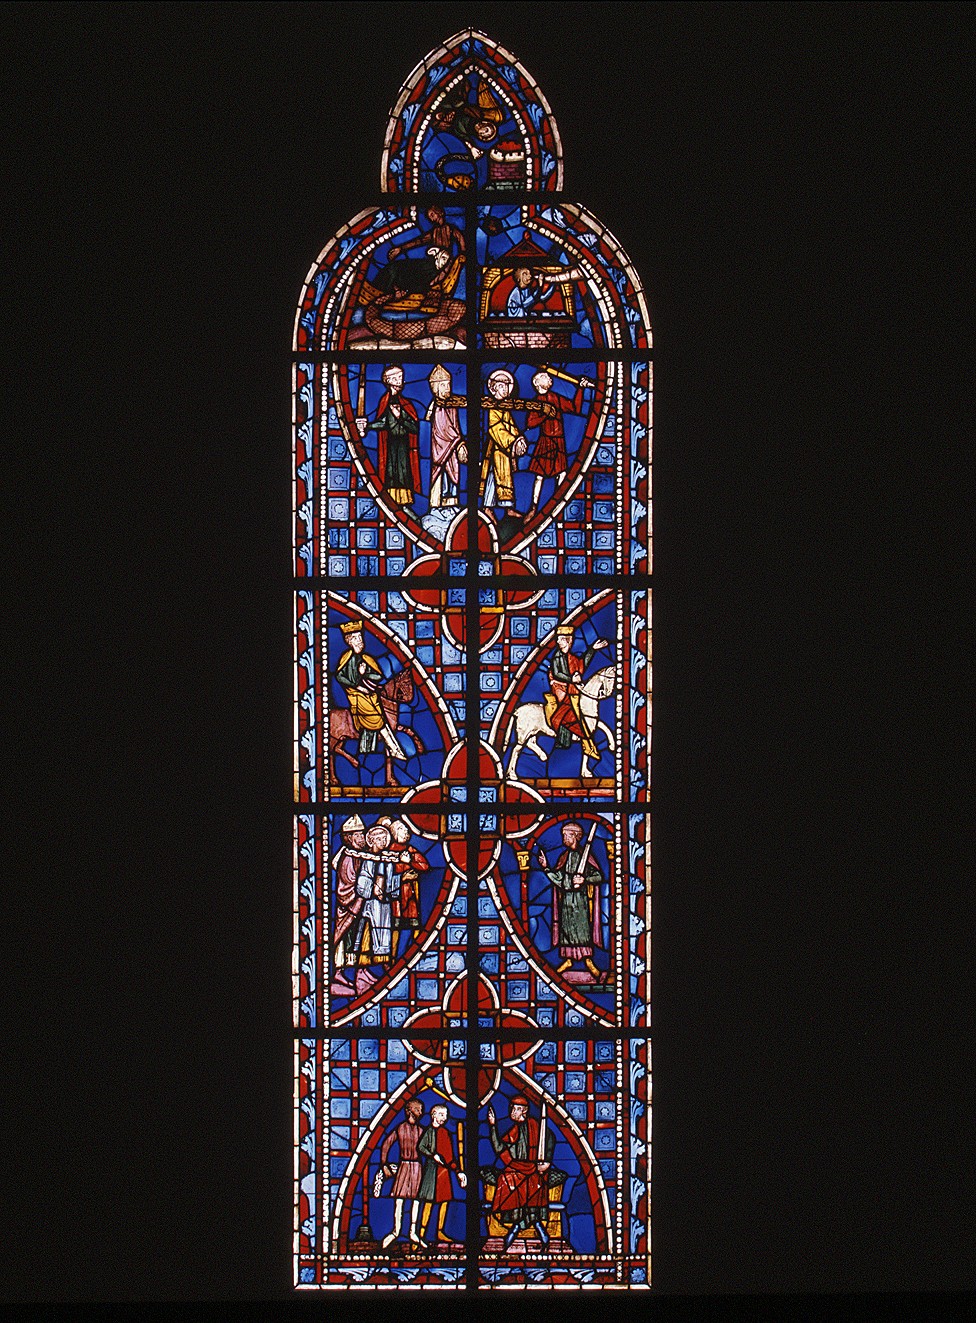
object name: window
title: Scenes from the Legend of Saint Vincent of Saragossa and the History of His Relics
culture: french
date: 1245-1247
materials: glass, lead, metal, paint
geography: france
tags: men,horses,saints